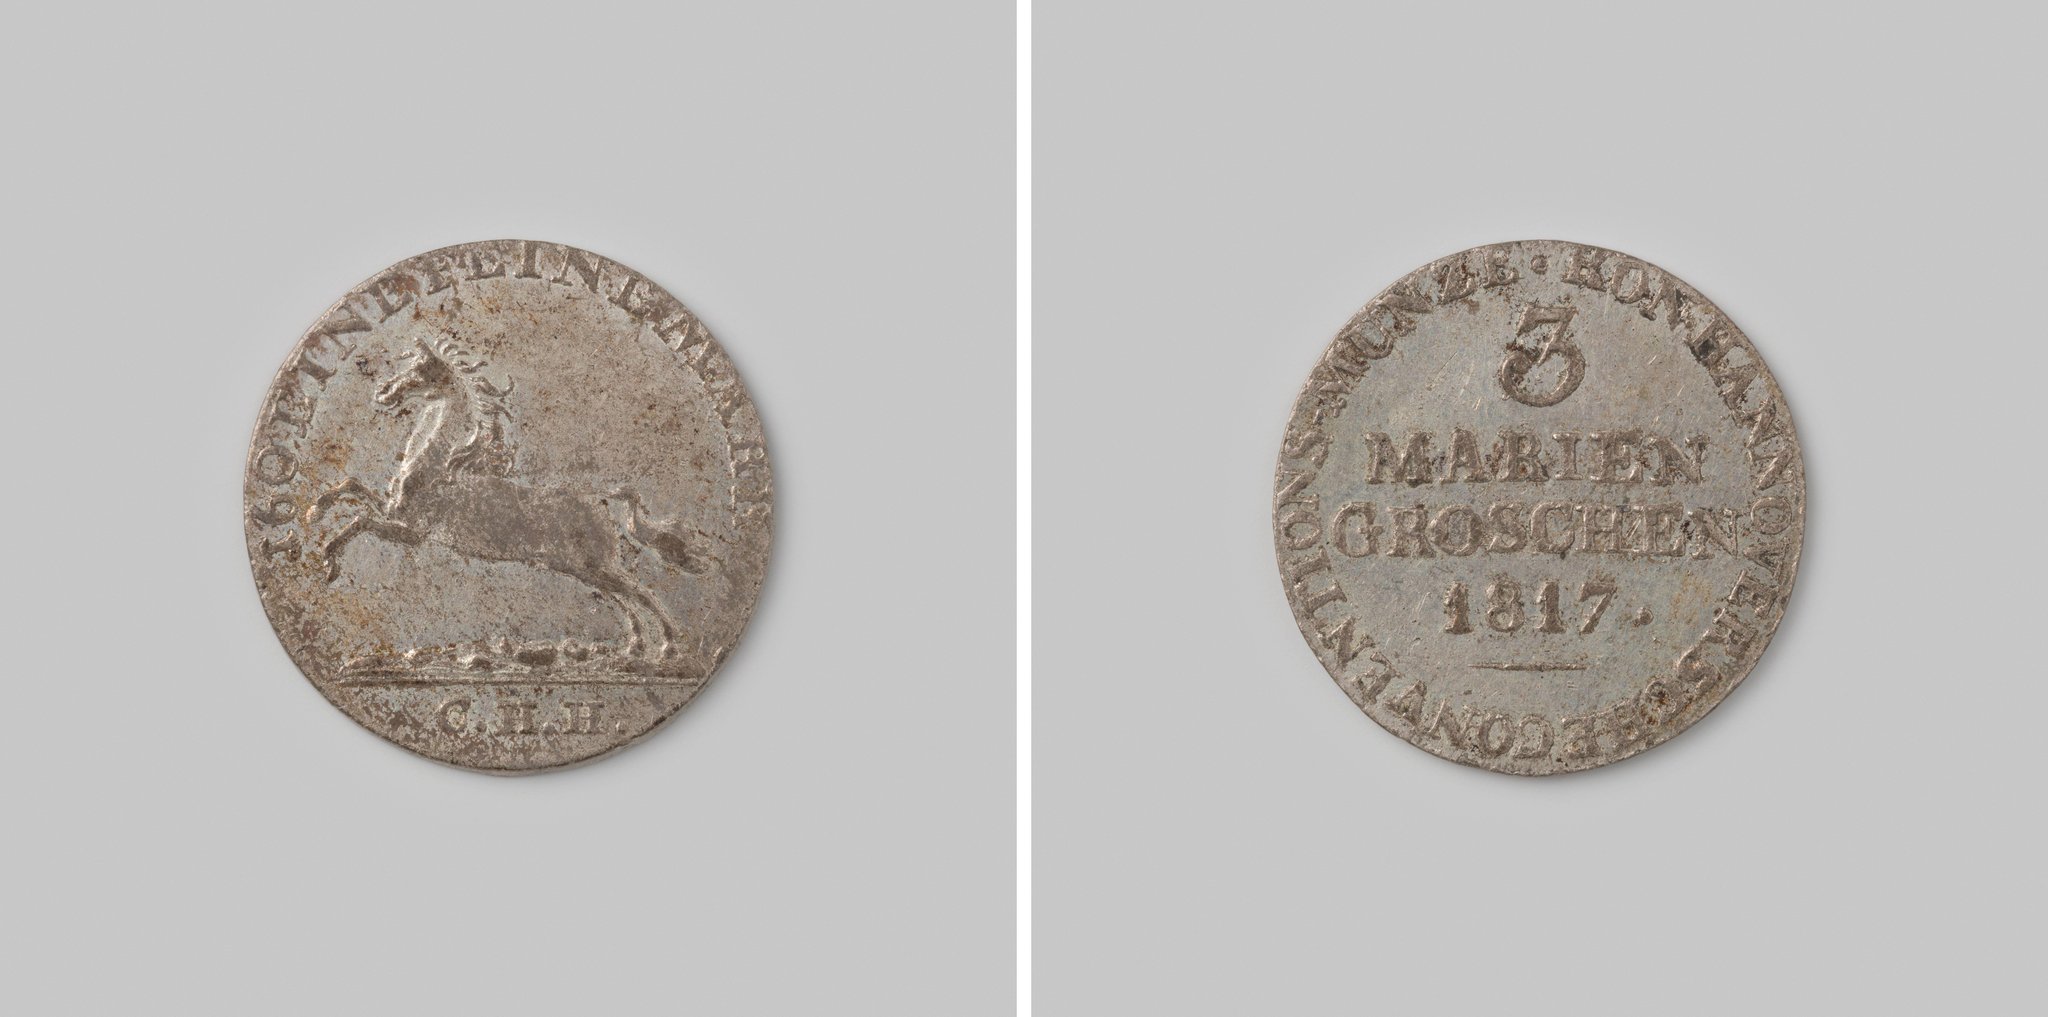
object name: drie mariëngroschen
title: 3 mariëngroschen uit het koninkrijk Hannover van Georg III, 1817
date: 1817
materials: silver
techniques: striking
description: Zilveren munt. Voorzijde: springend paard naar links op ondergrond. Daaronder letters C,H en H. Keerzijde: waarde-aanduiding in drie regels, waaronder jaartal. Gladde rand.